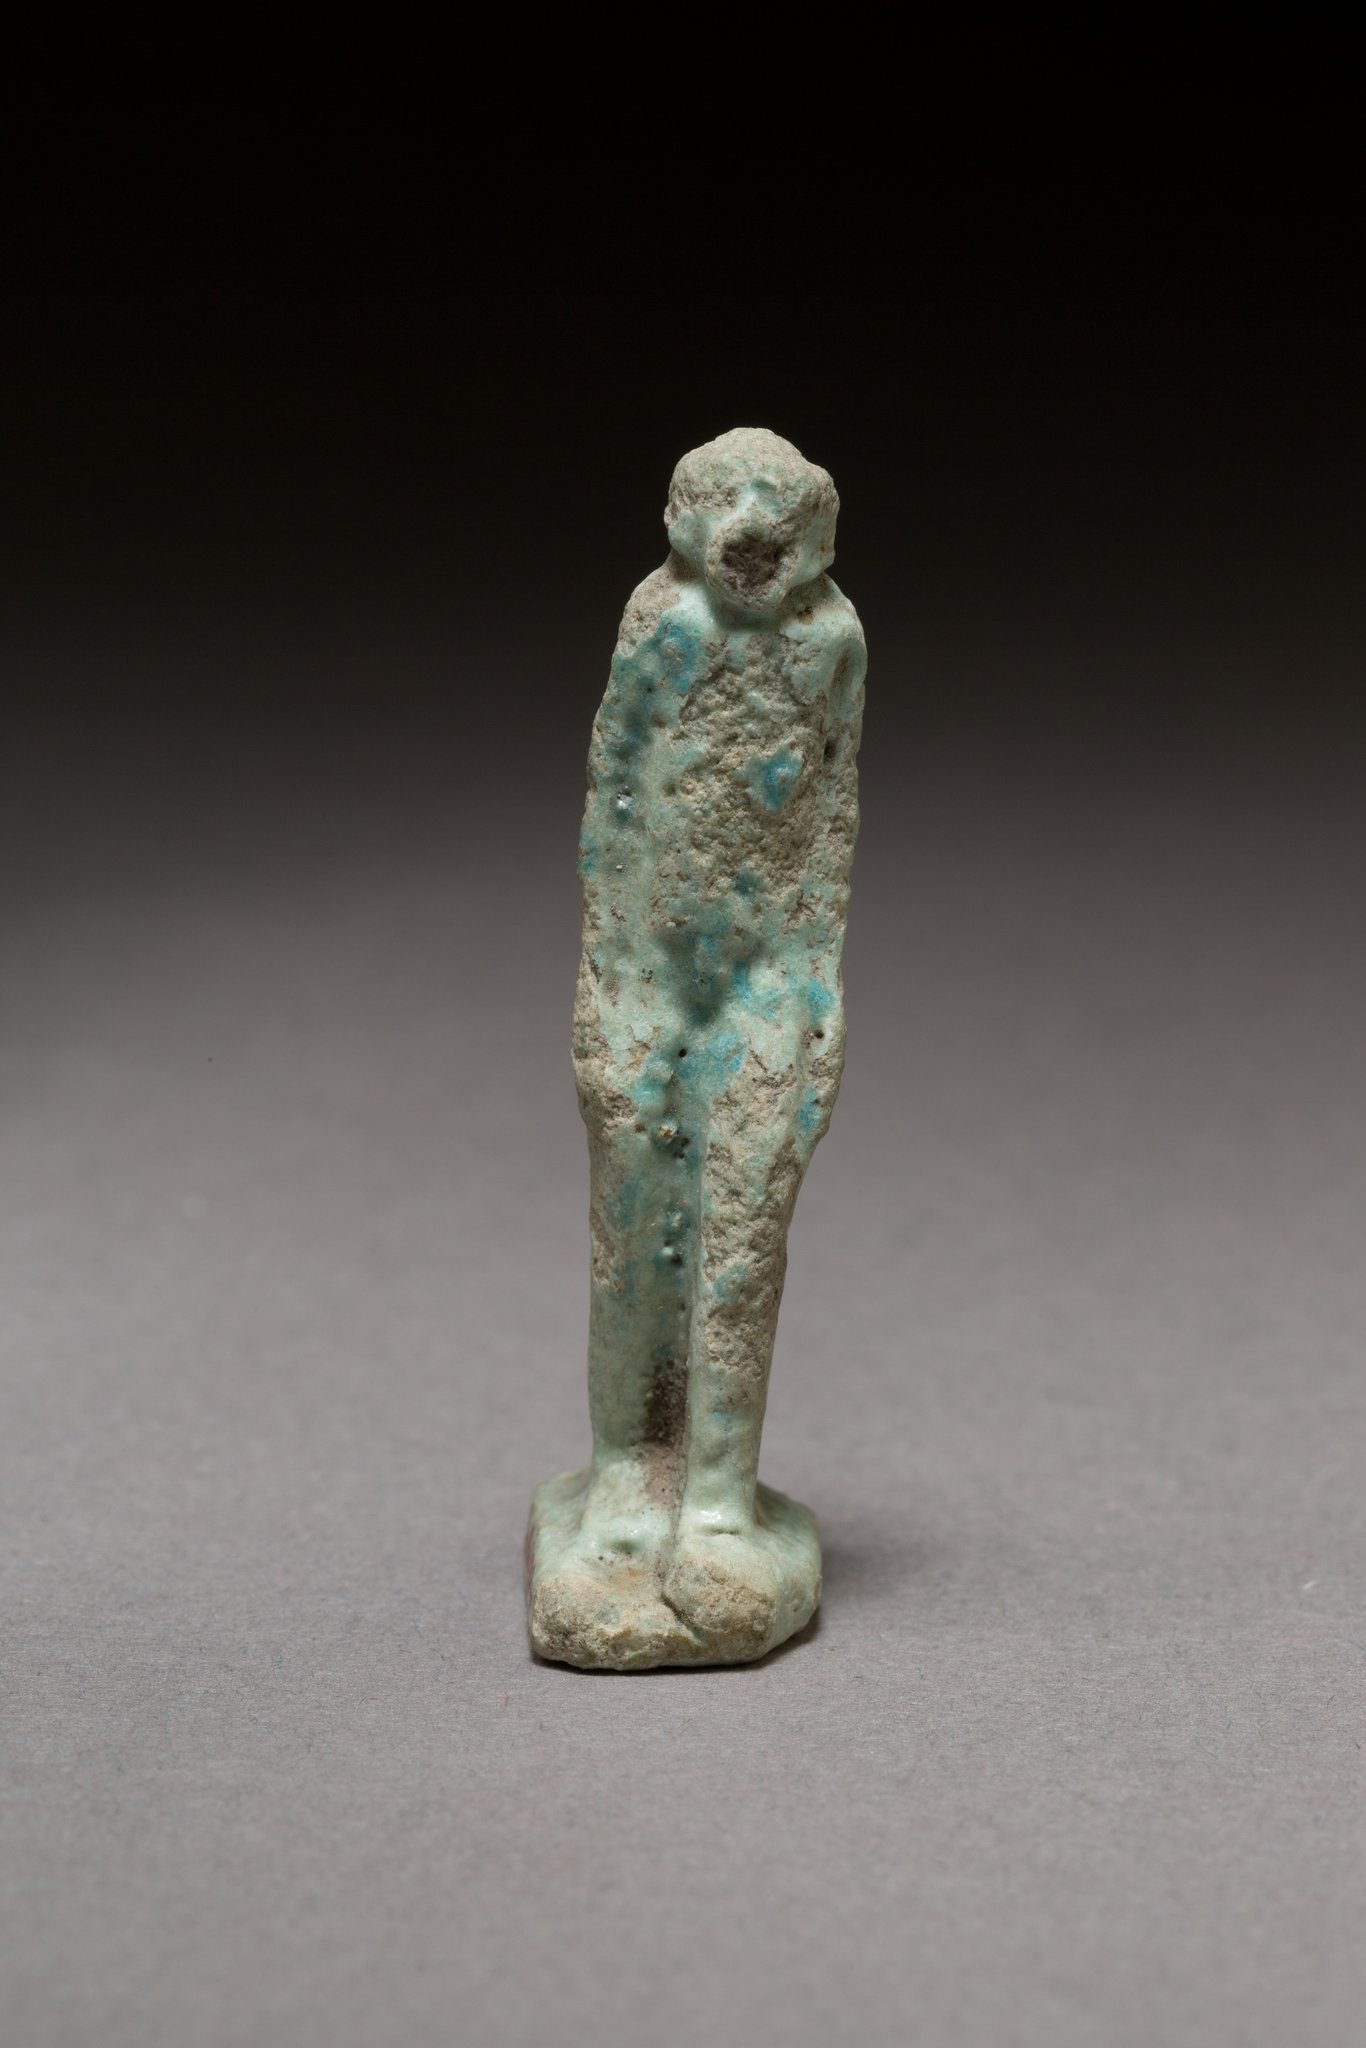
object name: amulet, monkey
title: Monkey or meerkat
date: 500-200 BCE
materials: faience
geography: egypt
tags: monkeys